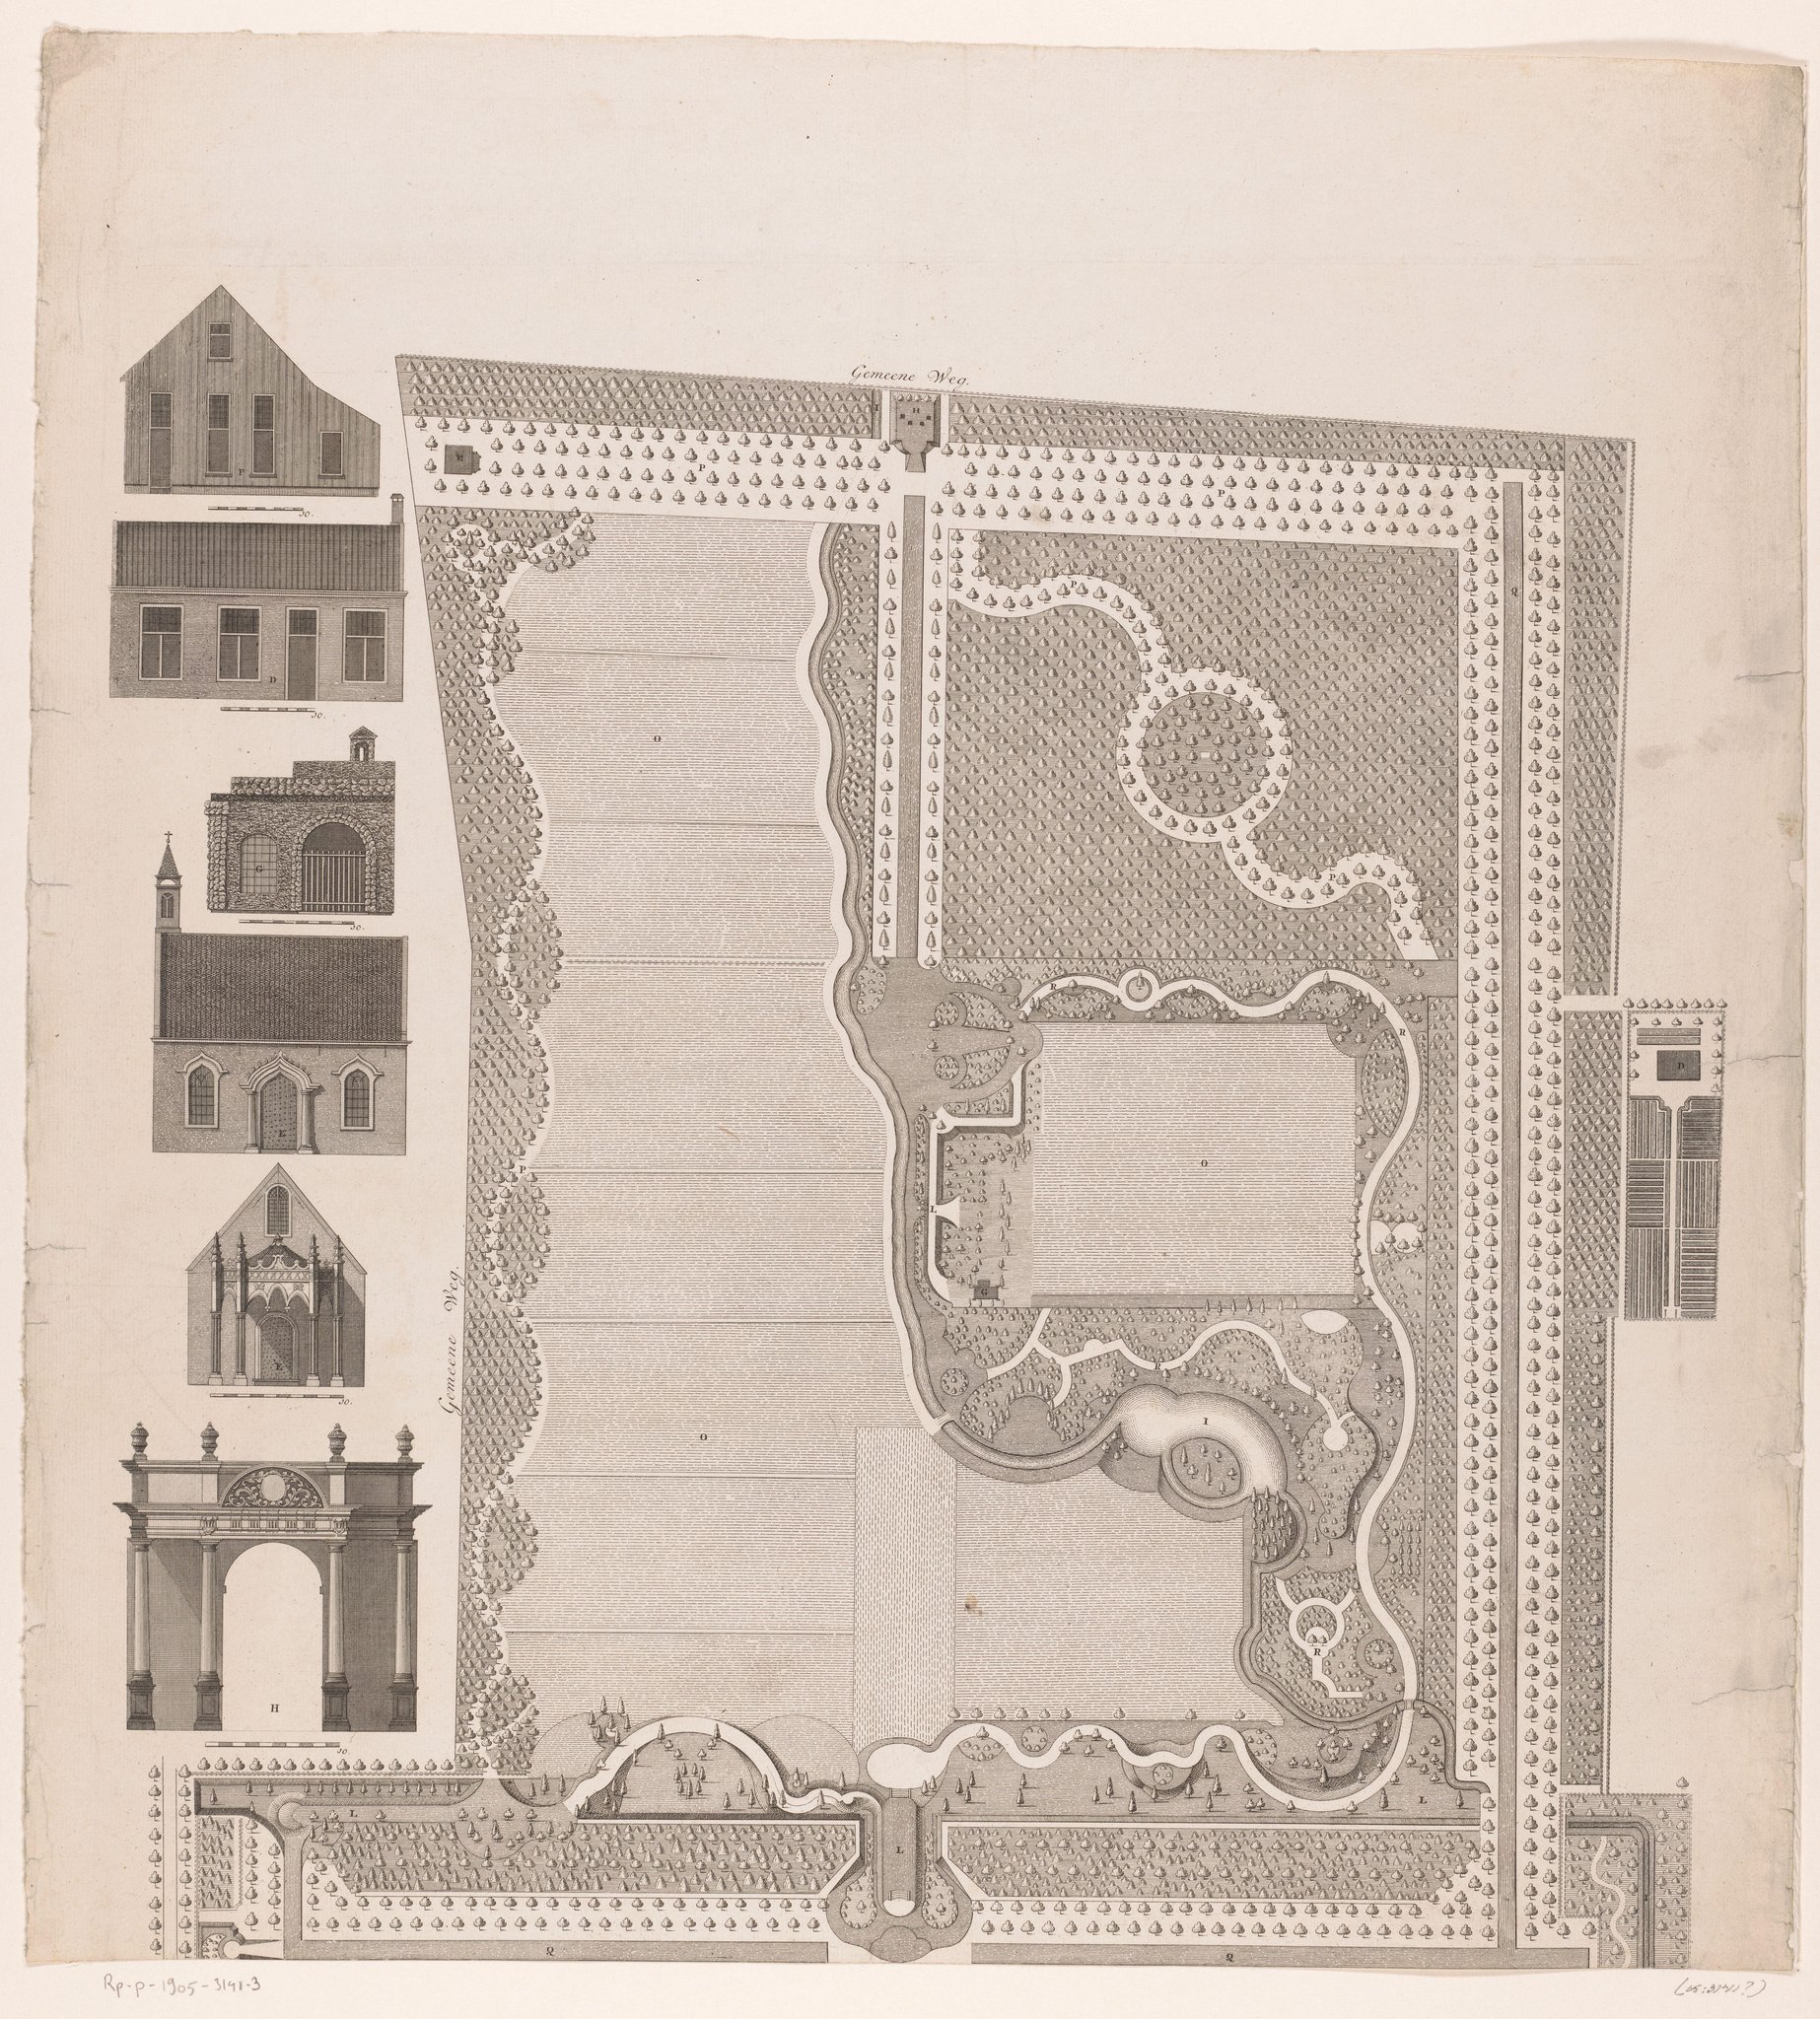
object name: print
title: Beeckesteyn, lustplaats van den wel Ed. Gestr. Heer Mr. Jacob Boreel (...) / Beeckesteyn, maison de campagne de monseigneur Mr. Jacob Boreel (...)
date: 1772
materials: paper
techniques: engraving, etching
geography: amsterdam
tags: french or architectonic garden; formal garden, garden buildings, armorial bearing, heraldry, country-house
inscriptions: date